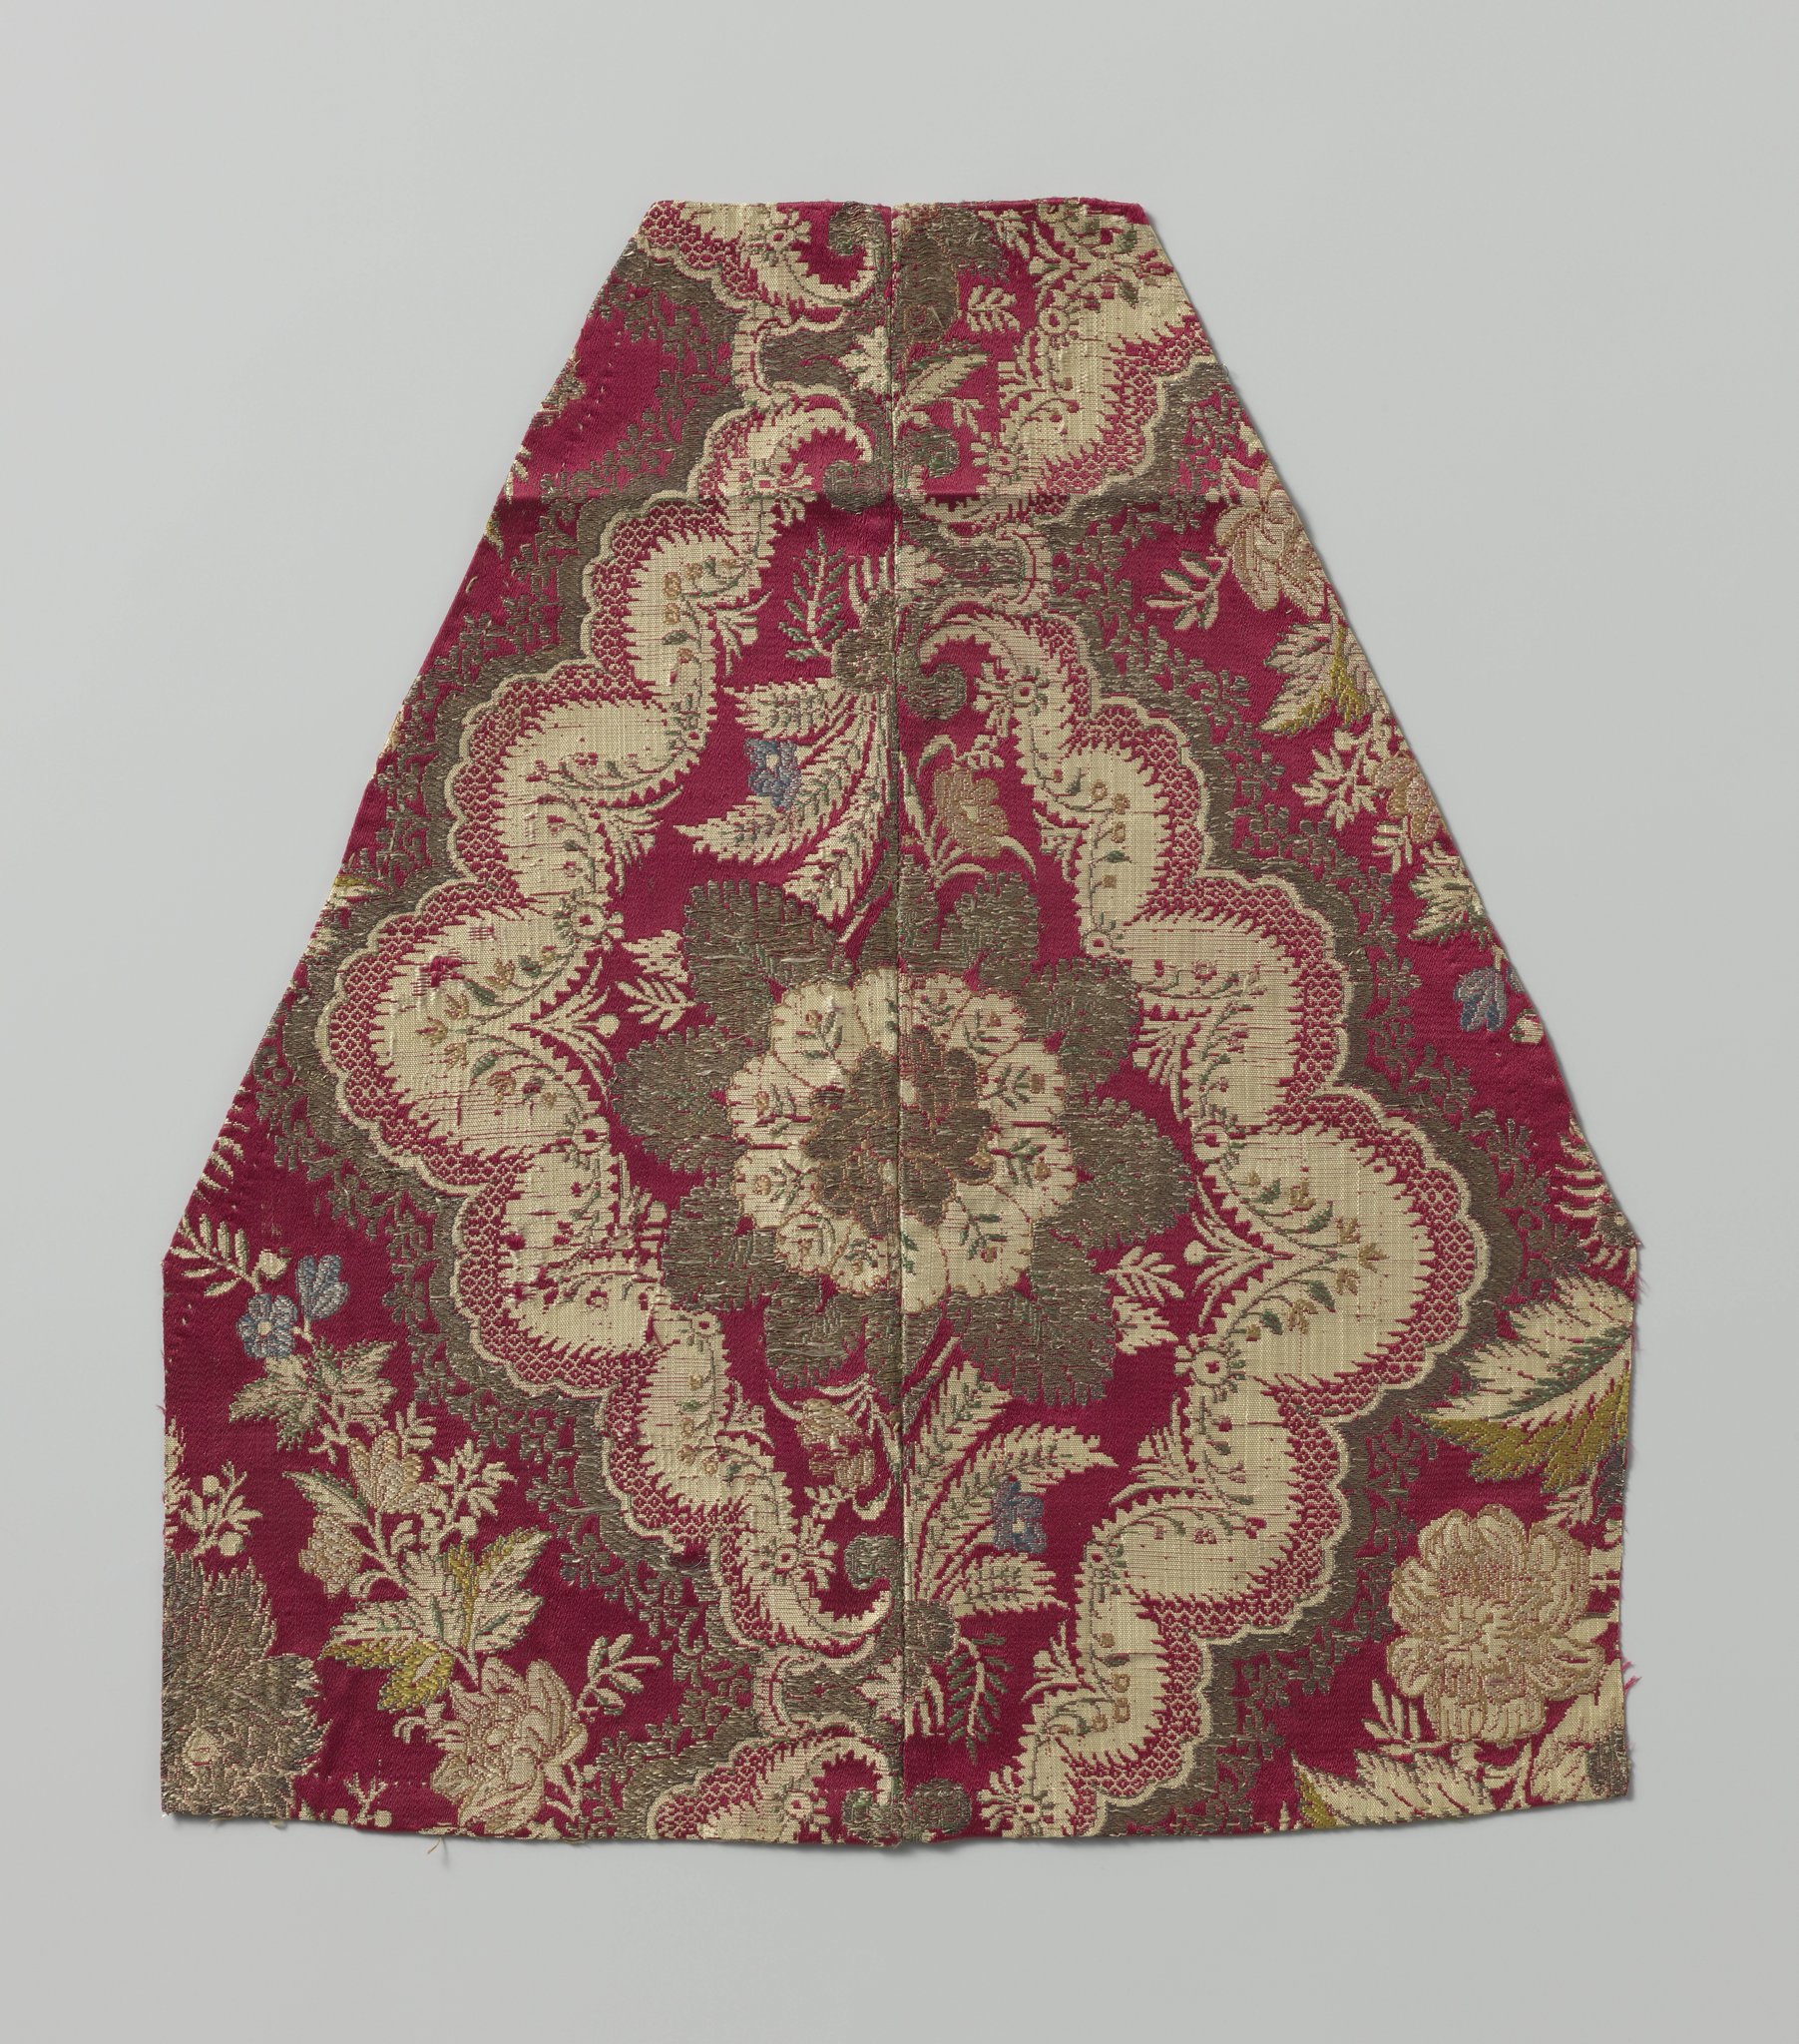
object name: fragment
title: Fragment van twee aan elkaar genaaide delen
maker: Anonymous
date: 1720-1730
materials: silk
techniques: lampas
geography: france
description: Fragment van twee aan elkaar genaaide delen, overwegend rood, met patroon van grote bloem in ruitvormige kantrand omgeven door bloem- en bladslingers.